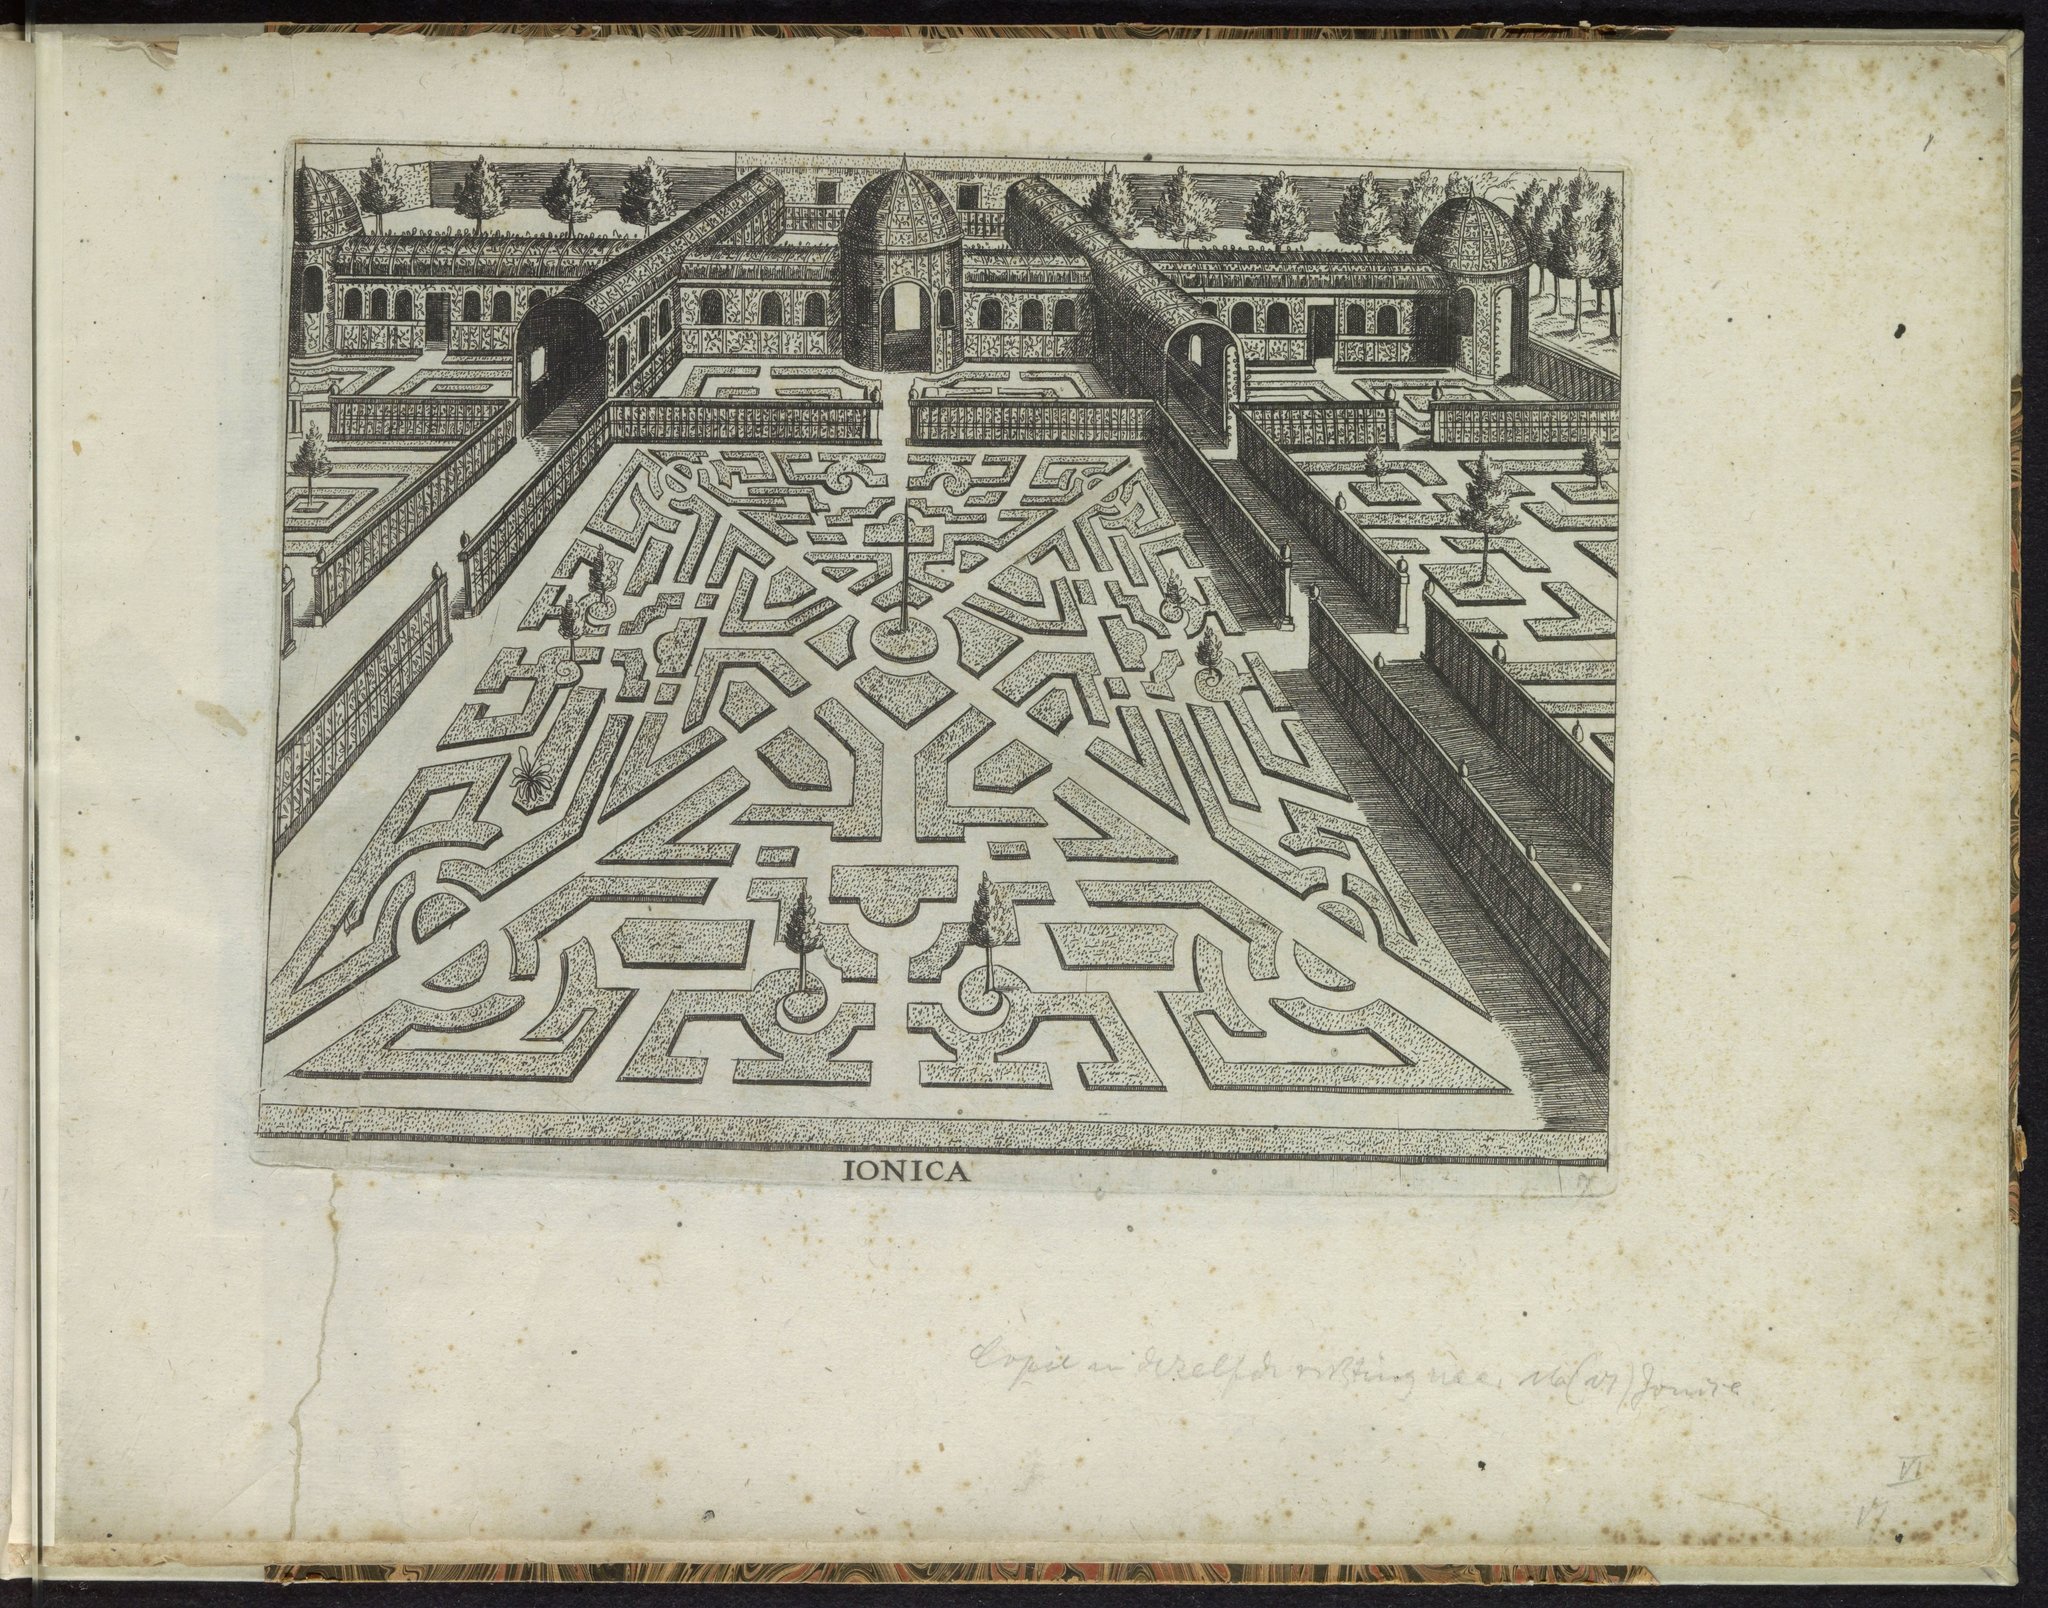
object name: print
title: Hortorum Viridariorumque elegantes et multiplicis formae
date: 1615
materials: paper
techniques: etching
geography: cologne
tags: garden, french or architectonic garden; formal garden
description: Tuin met parterre met diagonale paden. Op de achtergrond gangen van traliewerken en drie paviljoens. De tuin is aangelegd volgens de Ionische bouworde. De prent maakt deel uit van een album.